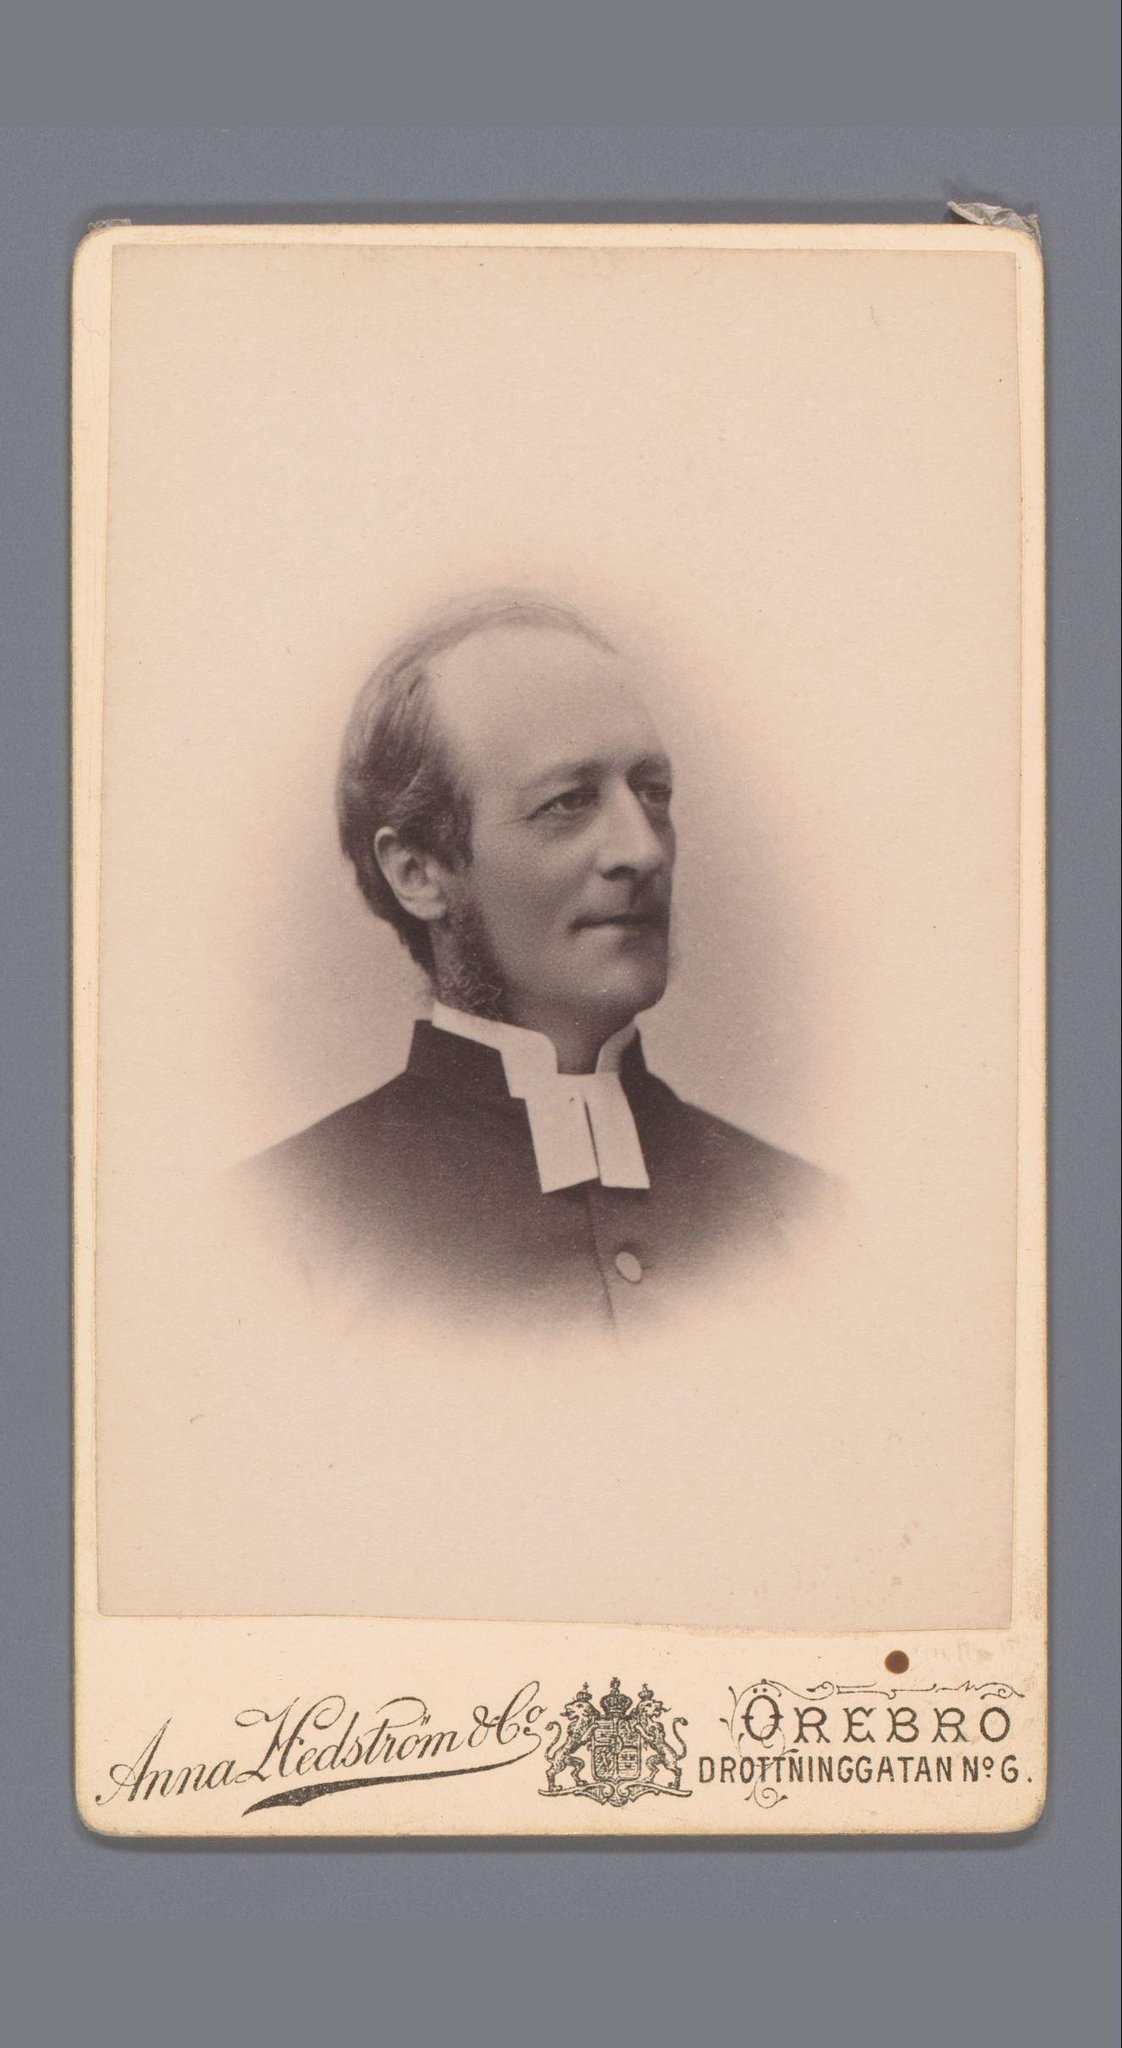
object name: photograph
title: Portret van een onbekende man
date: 1892-1910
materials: cardboard, paper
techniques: albumen print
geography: orebro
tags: adult man, historical persons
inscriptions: inscription: ‘Dr. Venning Wendell’, inscription: ‘ÖREBRO/ DROTTNINGGATAN No. 6.’